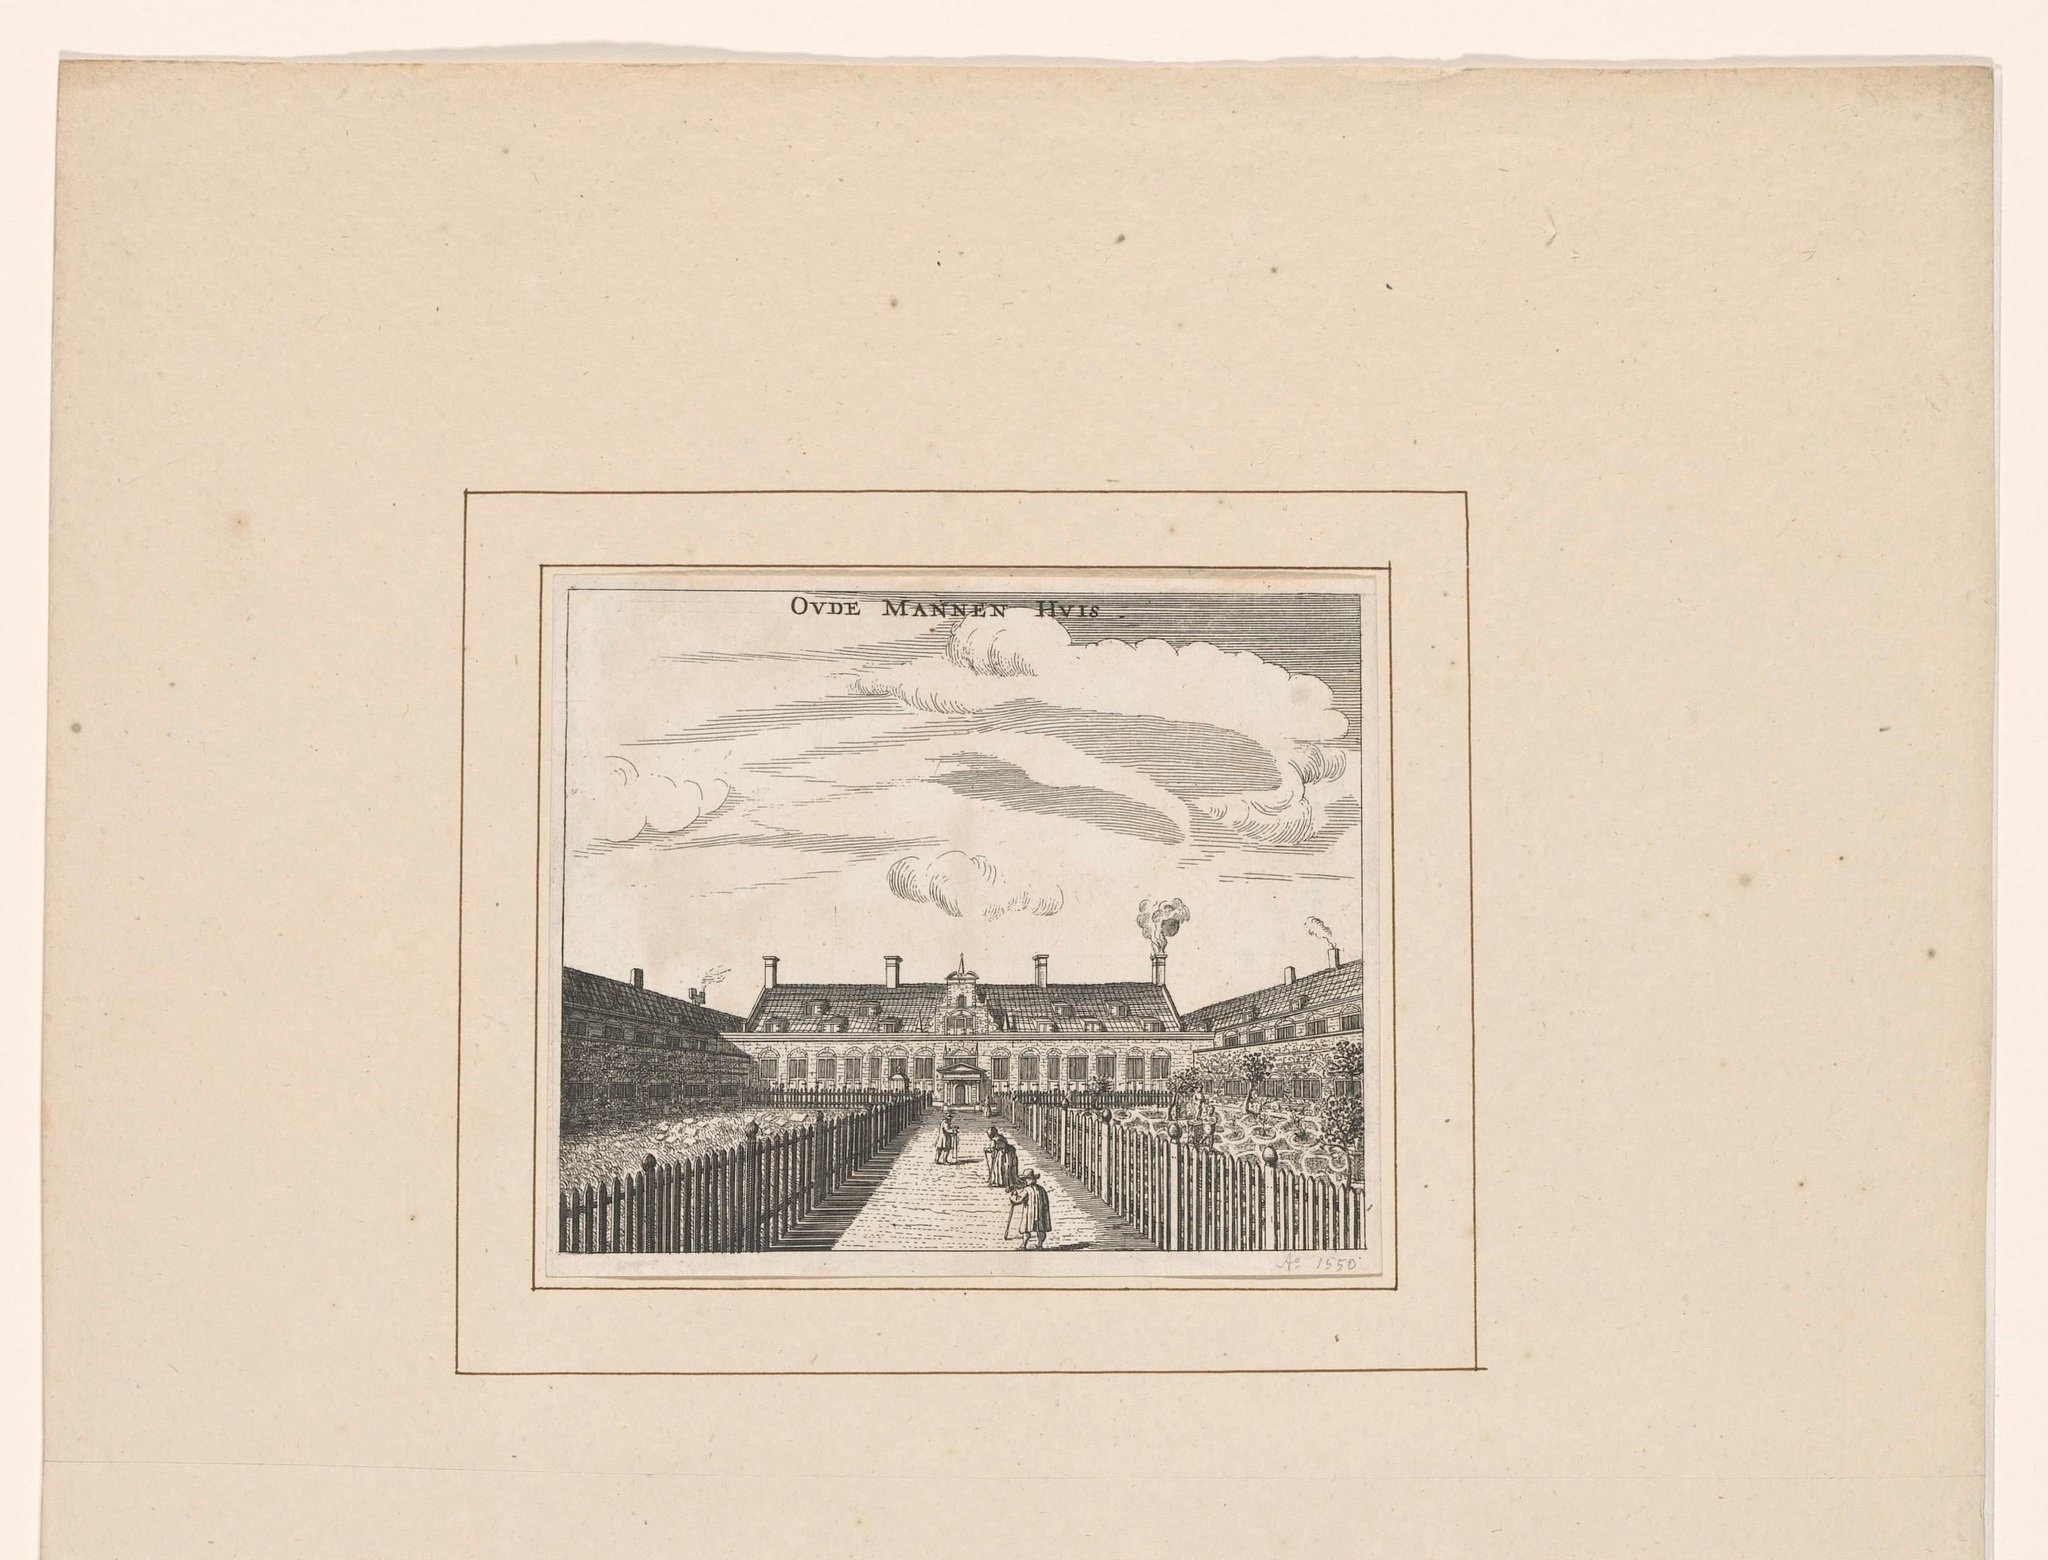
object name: book illustration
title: Oude Mannen Huis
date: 1664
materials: paper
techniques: engraving, etching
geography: amsterdam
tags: public welfare, poorhouse, french or architectonic garden; formal garden, courtyard, old-people's home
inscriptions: collector's mark: Lugt 195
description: Huidige staat van prent ook gebruikt in: Fockens, Melchior. Beschrijving Der wijdt-vermaarde Koop-stadt Amstelredam, Van haar eerste beginselen, zedert den Jare 1203. oude Voorrechten, verscheyde Vergrootingenoude Voor-rechten, en verscheyde Vergrootingen (…). 3e druk. Amsterdam: Marcus Willemsz. Doornick, 1664. En in: Zesen, Philipp von. Beschrybung der Weidtberuhmde Kauf-Stadt Amstelredam / Beschreibung der Stadt Amsterdam darinnen von derselben ersten ursprunge bis auf gegenwartigen zustand (…). Amsterdam: Marcus Willemsz. Doornick, 1664. Tweede bekende staat (met toevoeging Franse titel) ook gebruikt in: Domselaer, Tobias en Isaac Commelin. Beschryvinge van Amsterdam : haar eerste oorspronk uyt den huyze der heeren van Aemstel en Aemstellant (…). 6 delen. Amsterdam: Marcus Willemsz van Doornick, 1665. Derde bekende staat (rechtsboven genummerd: 27) ook gebruikt in verschillende latere zeventiende- en achttiende-eeuwse publicaties.